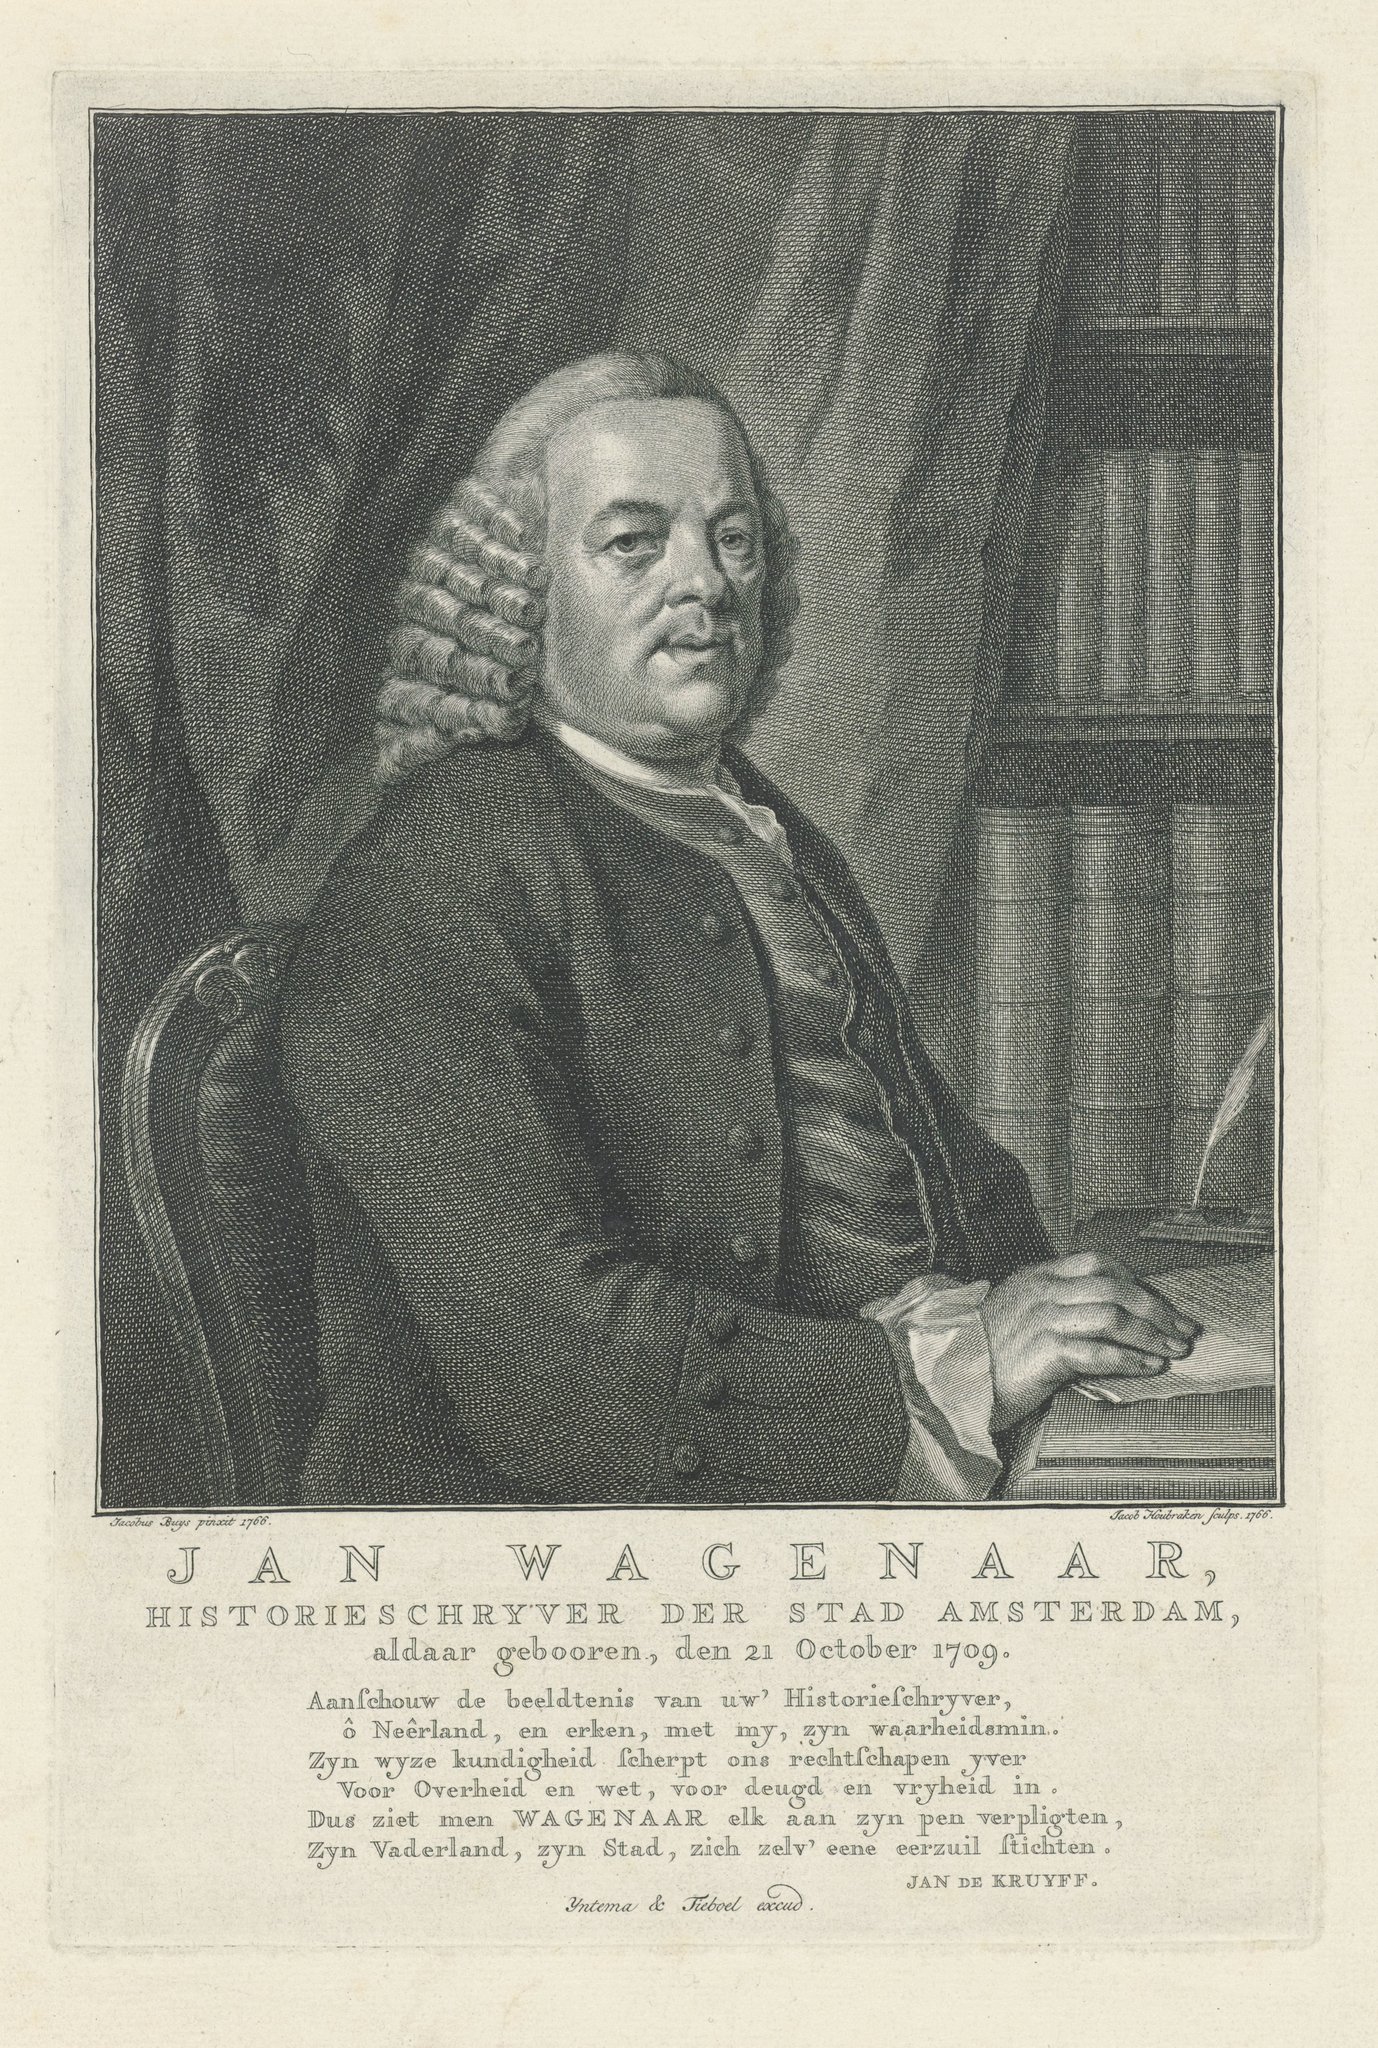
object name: print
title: Jan Wagenaar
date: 1766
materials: paper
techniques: engraving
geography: amsterdam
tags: amsterdam, jan wagenaar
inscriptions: collector's mark: Lugt 2228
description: Portret ten halven lijve naar rechts van Jan Wagenaar, zittend aan een schrijftafel met achter hem een boekenkast. Onder het portret zijn naam en gegevens in drie regels in het Nederlands en daaronder een een zesregelig vers in het Nederlands.